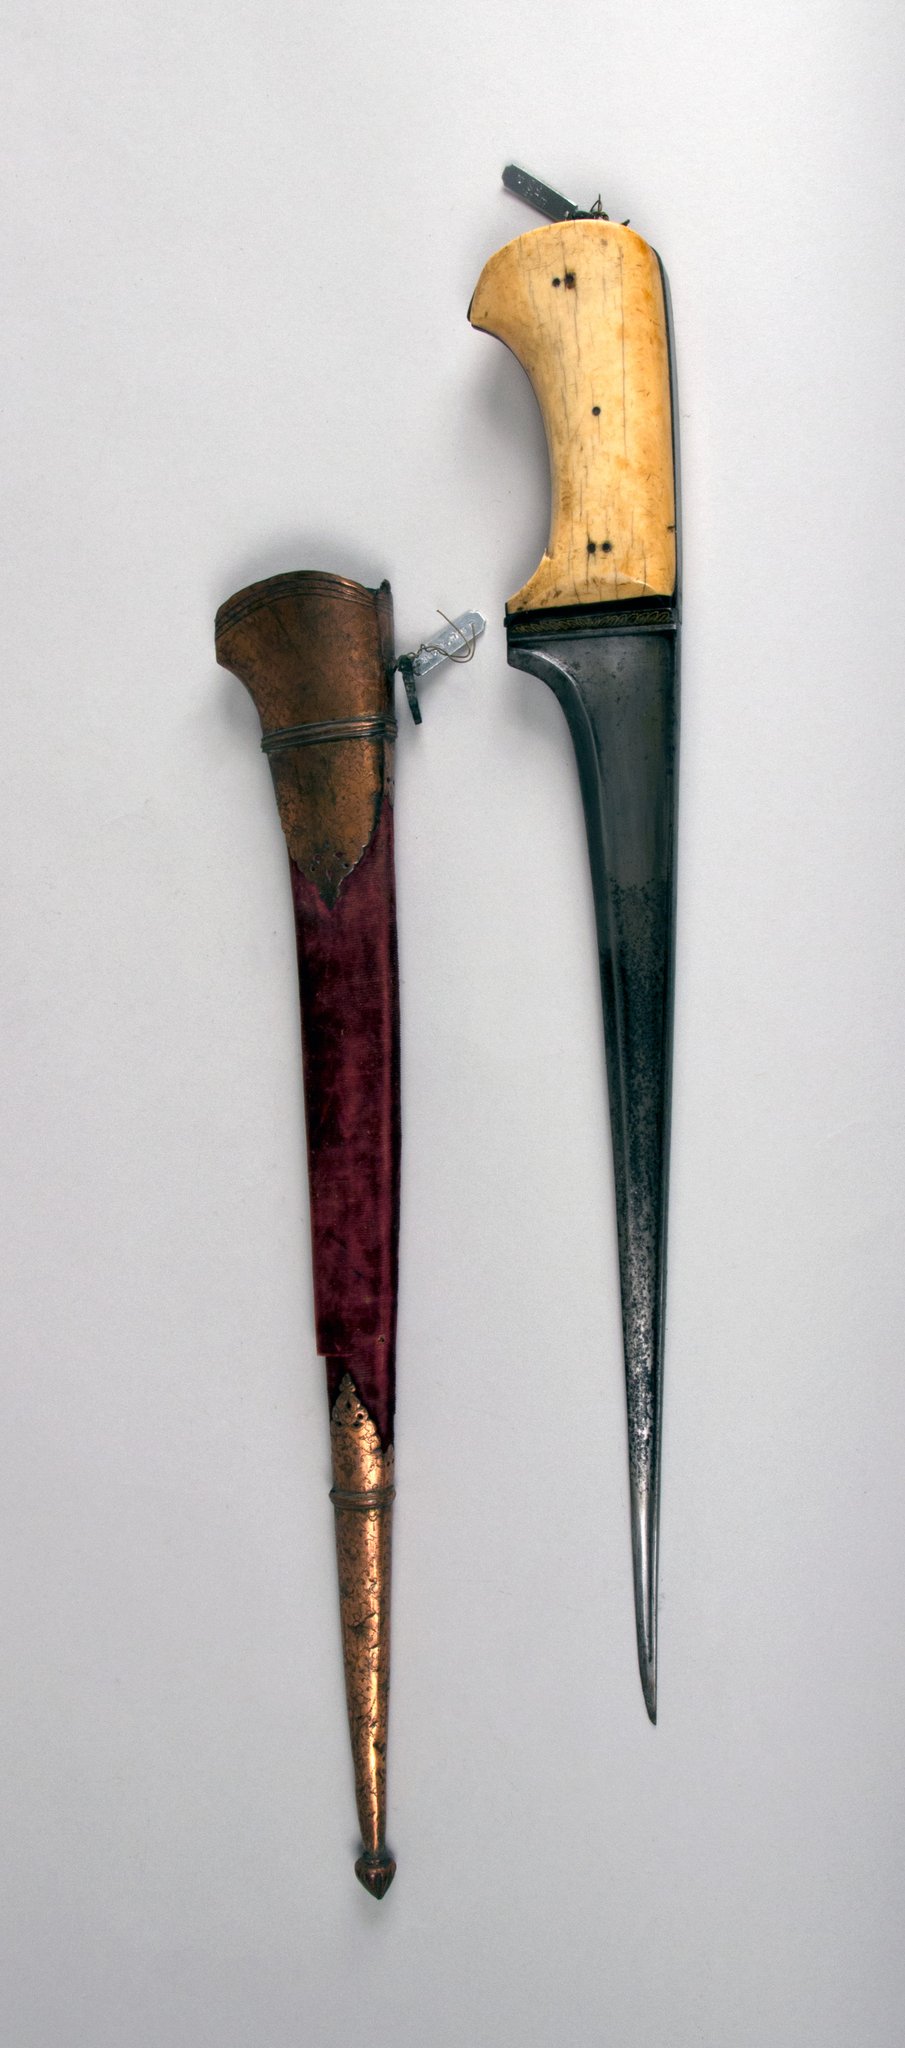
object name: dagger pesh kabz with sheath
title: Dagger (Pesh-kabz) with Sheath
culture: indian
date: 1701-1900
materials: copper, gold, ivory, steel, velvet, wood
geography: india